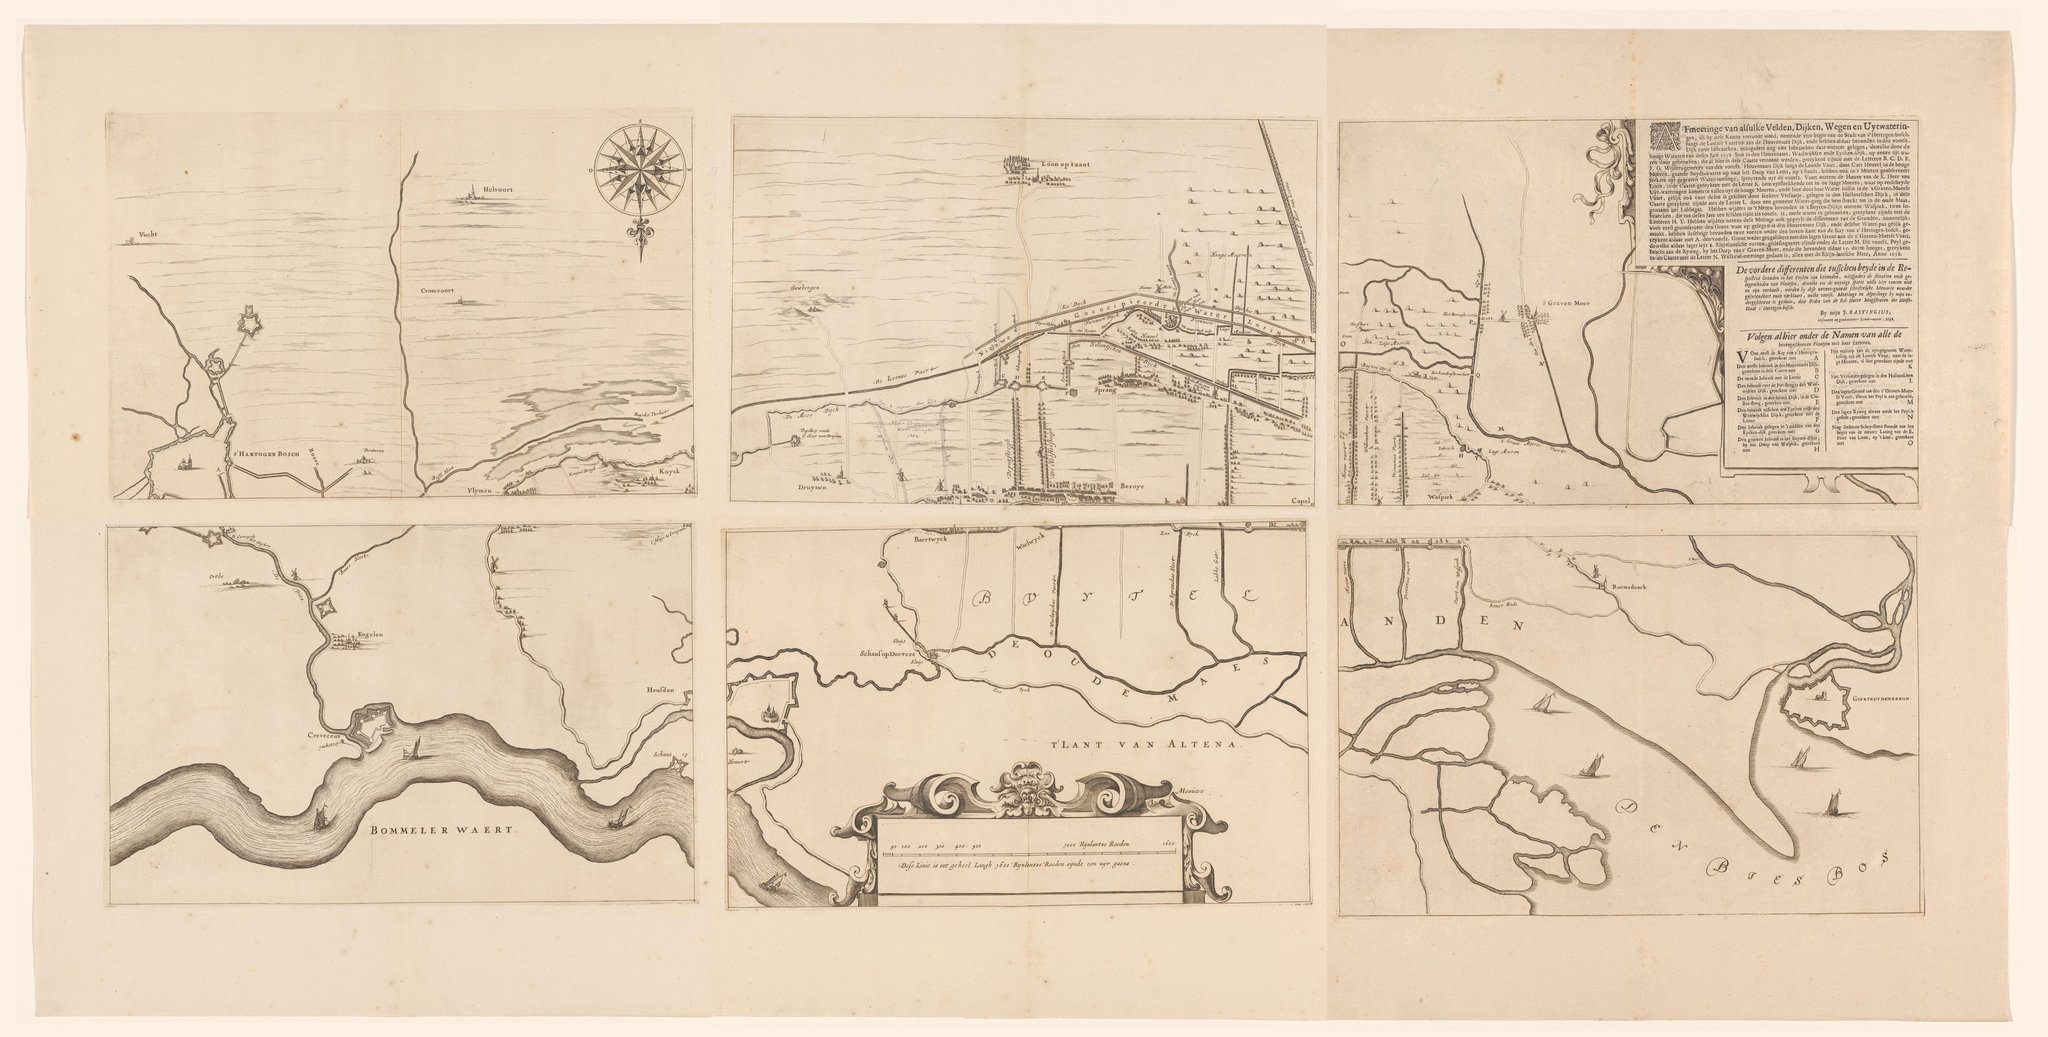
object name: map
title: Kaart van het gebied tussen Den Bosch en Geertruidenberg met dijkdoorbraken, bestaande uit zes bladen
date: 1658-1757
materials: ink, paper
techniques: engraving, etching, letterpress printing, pen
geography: den bosch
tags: maps of separate countries or regions, dikes, levee, gelderland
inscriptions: inscription: ‘< te stigtene Dijk >’, inscription: ‘< den te stigtene Meer Dijk >’, inscription: ‘Geprojecteerde Dijk’, inscription: ‘Nader Geconcipieerde Water Losingh 1754’, inscription: ‘Geprojecteerde Dijk’, collector's mark: Lugt 195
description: Dit object is omwille van een betere presentatie virtueel samengevoegd maar bestaat fysiek uit losse onderdelen. Deze kaart is voor het eerst gedrukt in 1658 en zonder aanpassingen in ieder geval nog een keer herdrukt in 1701. Vervolgens zijn in 1757 twee van de zes platen (de tweede en vijfde) bijgewerkt en is de kaart nog een keer gedrukt. Van het eerste, derde, vierde en zesde blad is dus één staat bekend terwijl er van het tweede en vijfde blad twee staten zijn. Het tweede en vijfde blad van de huidige kaart zijn de eerste staat, maar op beide bladen zijn met de hand precies de veranderingen aangebracht die op de tweede staat van 1757 te zien zijn. Vermoedelijk is de huidige kaart zo een voorstudie voor de tweede staat. Het is echter onduidelijk of de hiervoor gebruikte bladen oude bladen van een eerdere druk zijn of dat de kaart ter voorbereiding van de tweede staat opnieuw gedrukt is – vandaar de datering 1658 tot in of voor 1757.